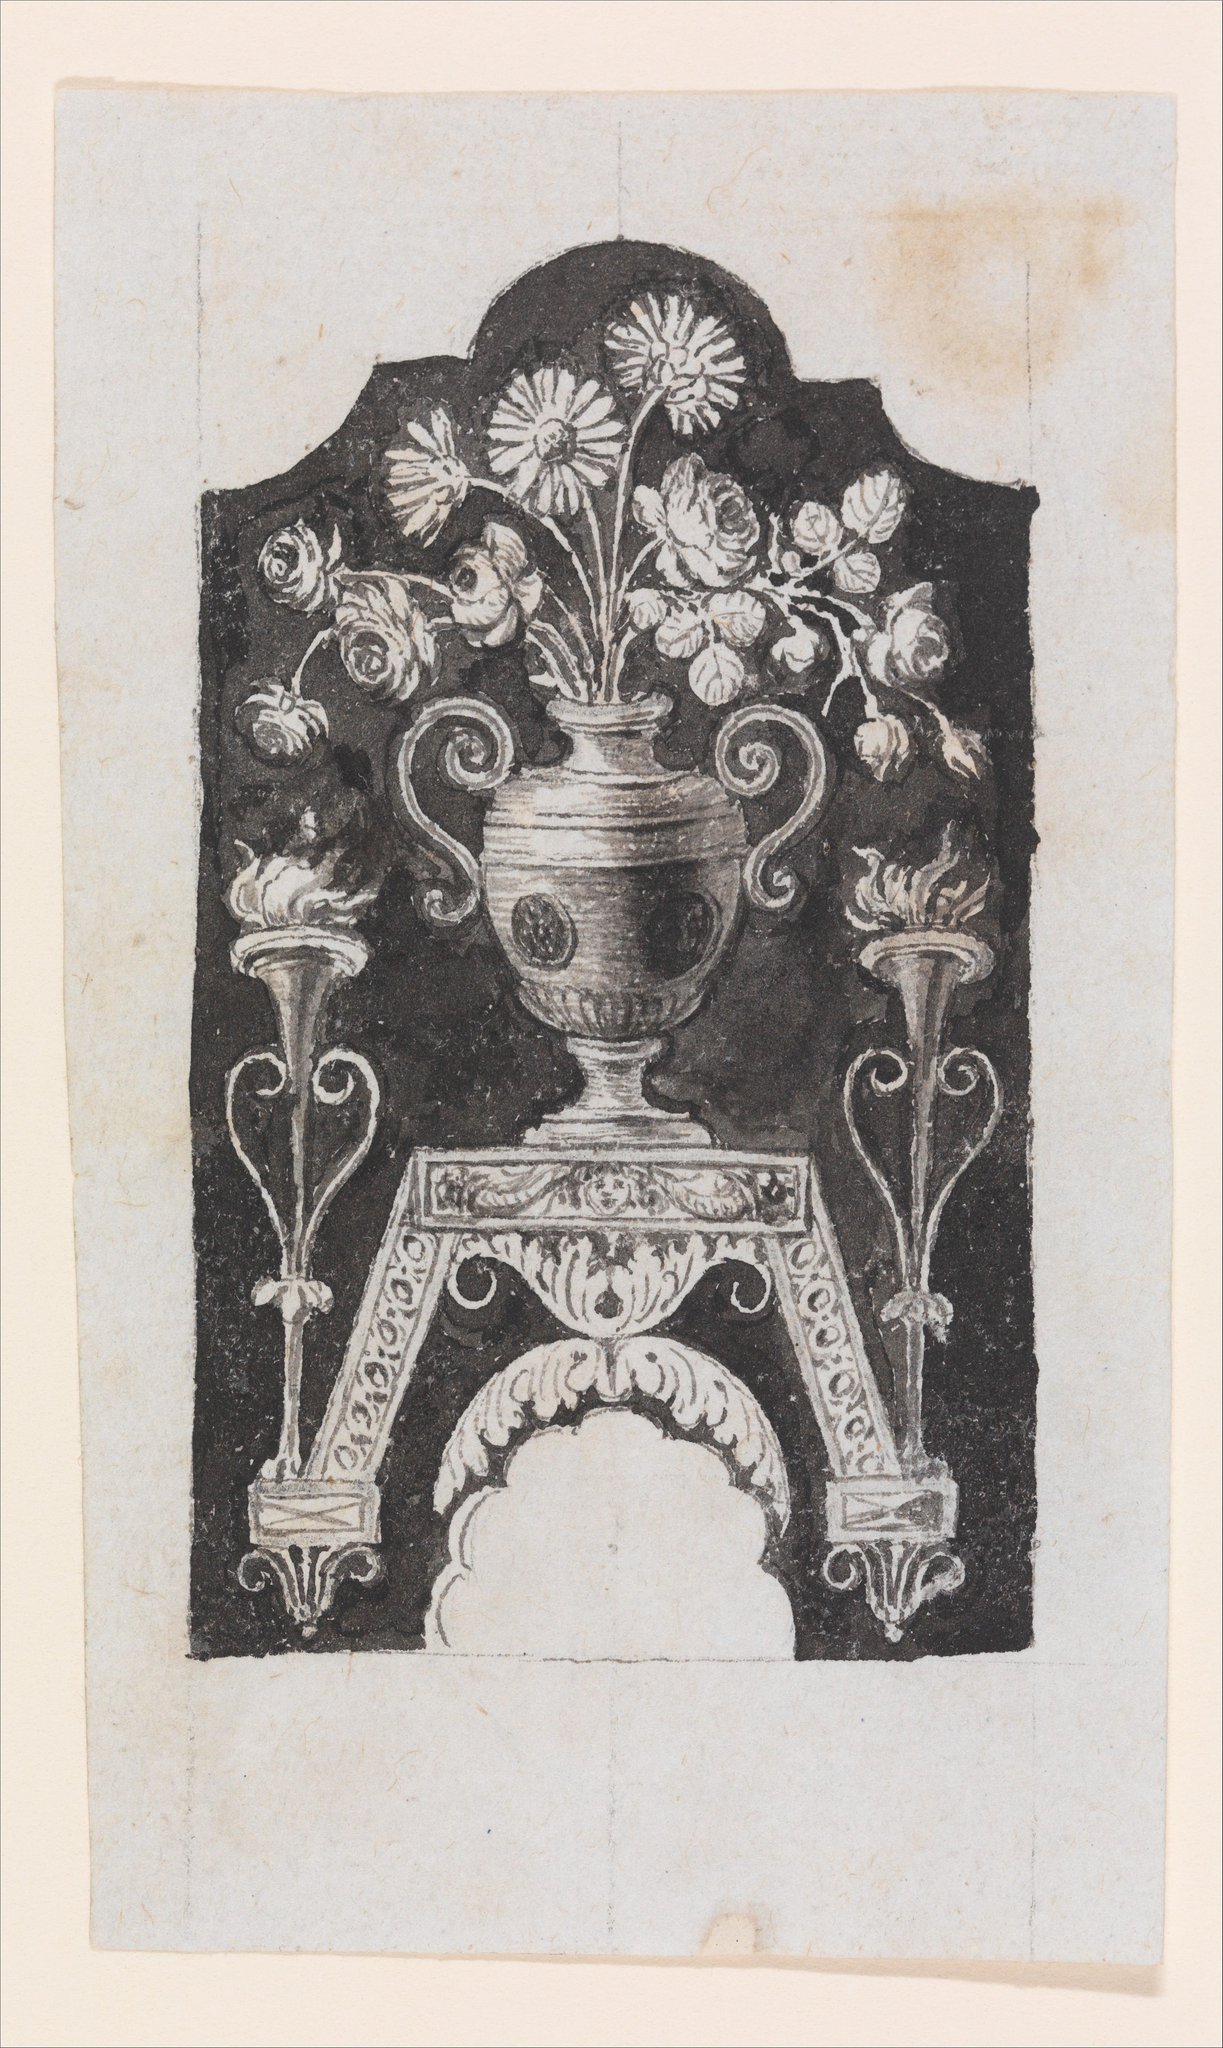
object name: drawing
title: Design for the Decoration of the Surround of the Ramrod Pipe of a Firearm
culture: french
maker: nicolas noël boutet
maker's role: designer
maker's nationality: french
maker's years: 1761-1833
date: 1795-1805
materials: ink, paper, pencil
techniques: wash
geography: france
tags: ornament,flowers,vases